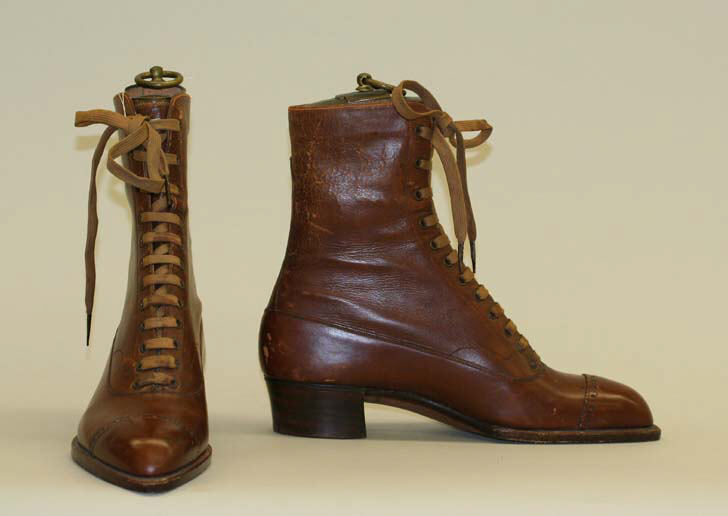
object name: oxford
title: Oxfords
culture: american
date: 1900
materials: leather